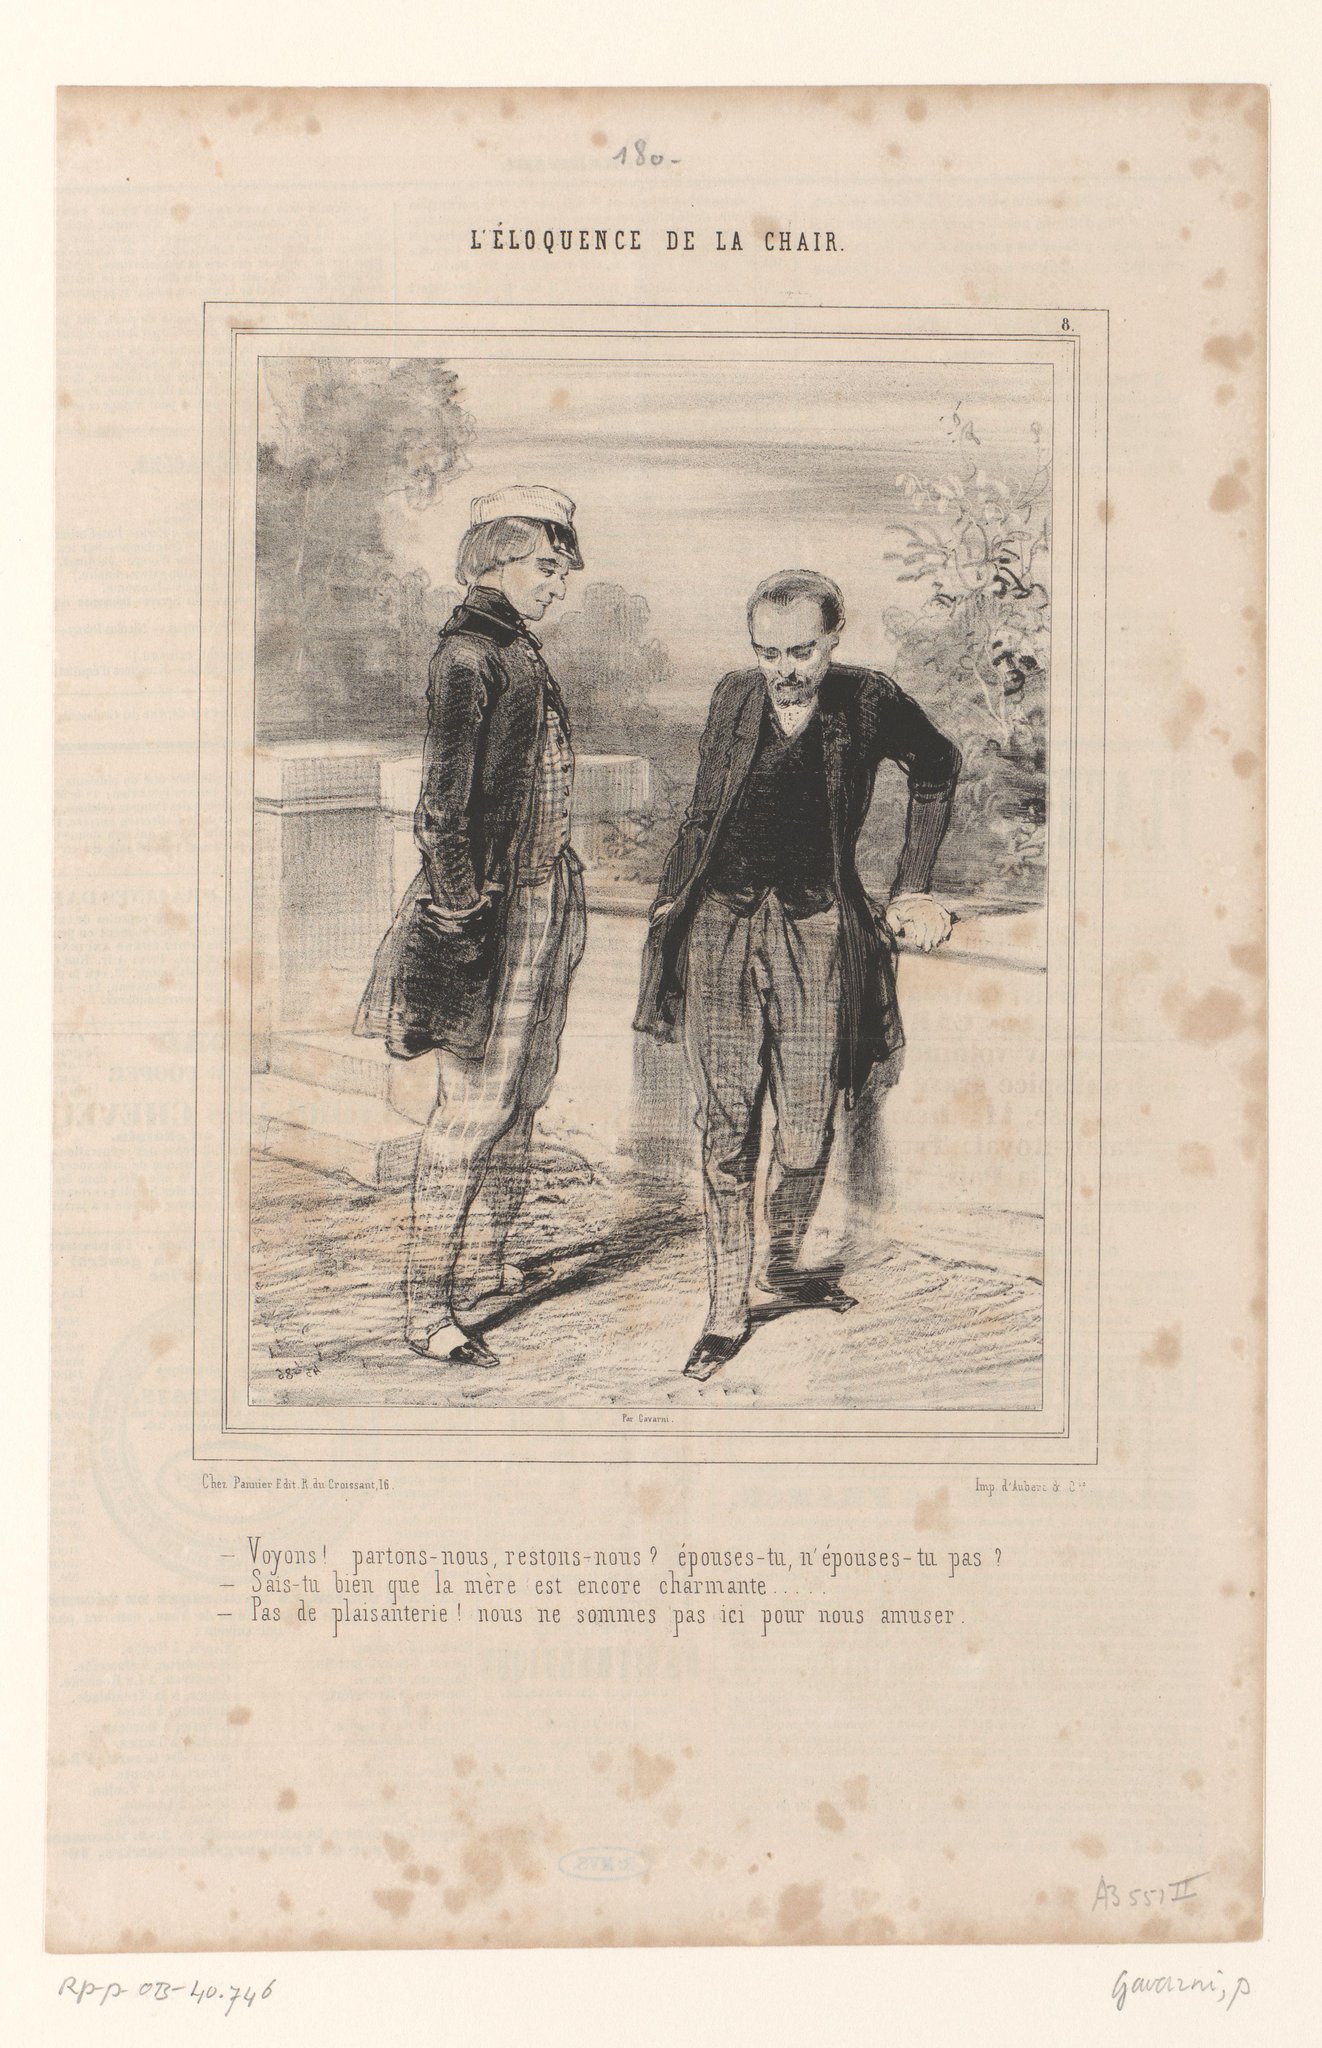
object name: print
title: Voyons! partons-nous, restons-nous? (...)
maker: paul gavarni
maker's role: draughtsman, print maker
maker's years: 1804-1866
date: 1843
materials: paper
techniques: lithograph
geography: paris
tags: standing figure, balustrade, conversation, dialogue; conversation piece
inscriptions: collector's mark: Lugt 2228a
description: De mannen discussiëren of ze zullen blijven of vertrekken. Dit hangt ervan af of de rechter man besluit om te trouwen.